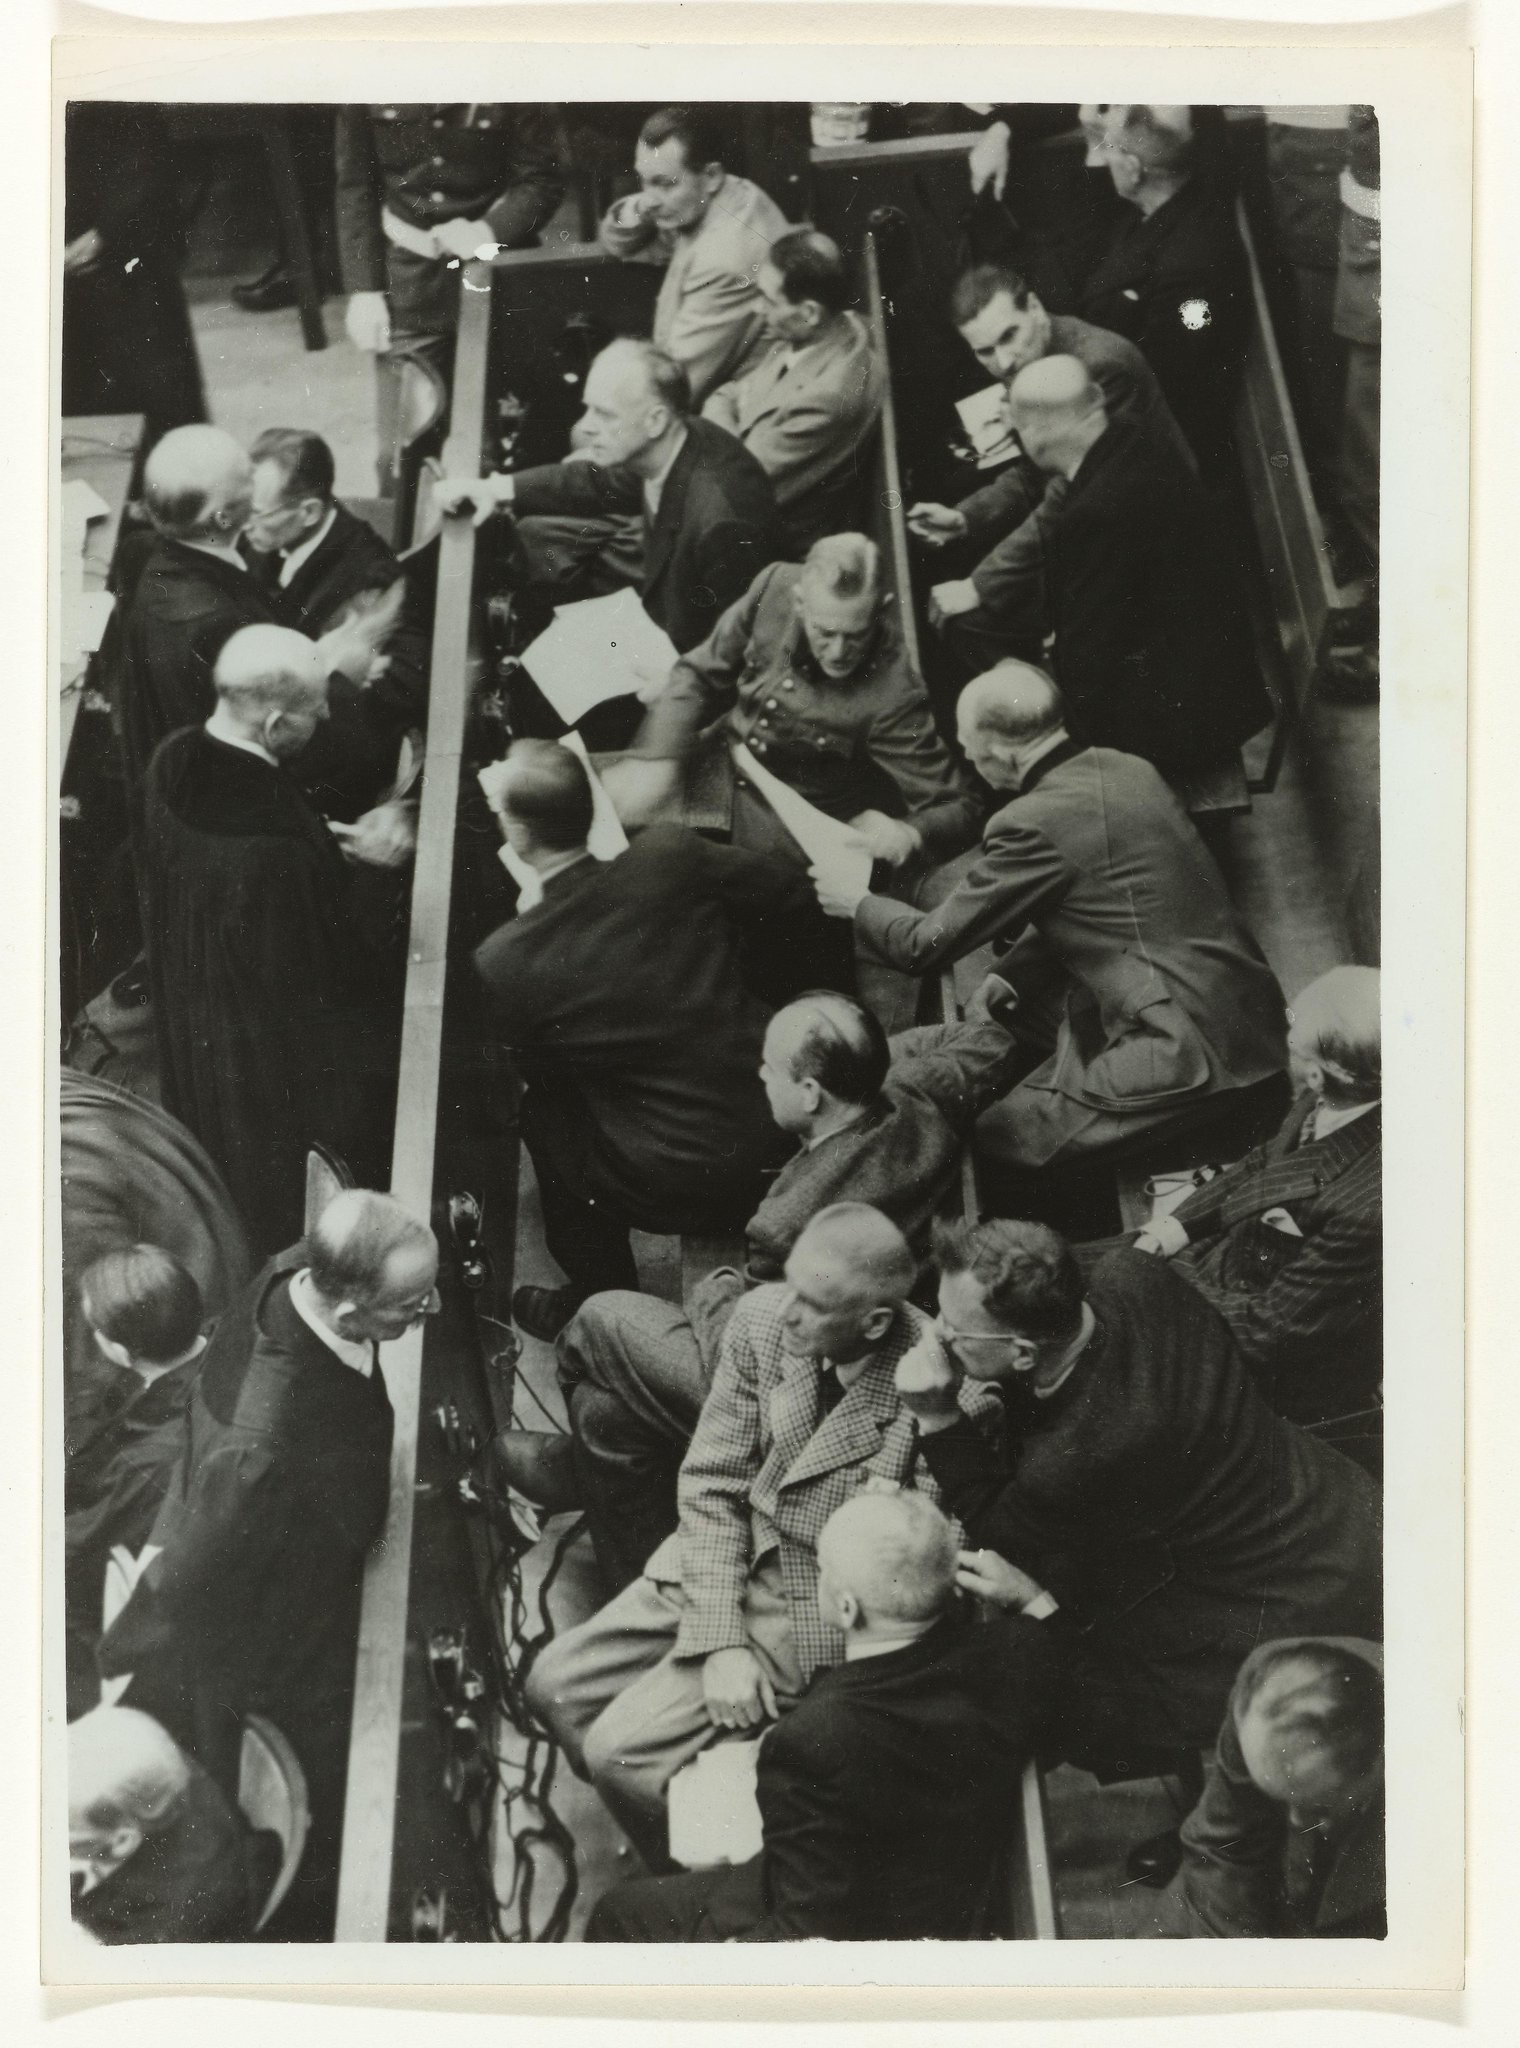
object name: photograph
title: Proces van Neurenberg: Seys-Inquart, Göring en Hess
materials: photographic support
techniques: photography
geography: nuremberg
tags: politician, arthur seyss-inquart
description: De beklaagdenbank tijdens het proces van Neurenberg. Seyss Inquart (rechts) en aan het eind van de bank zijn Göring en Hess te zien.